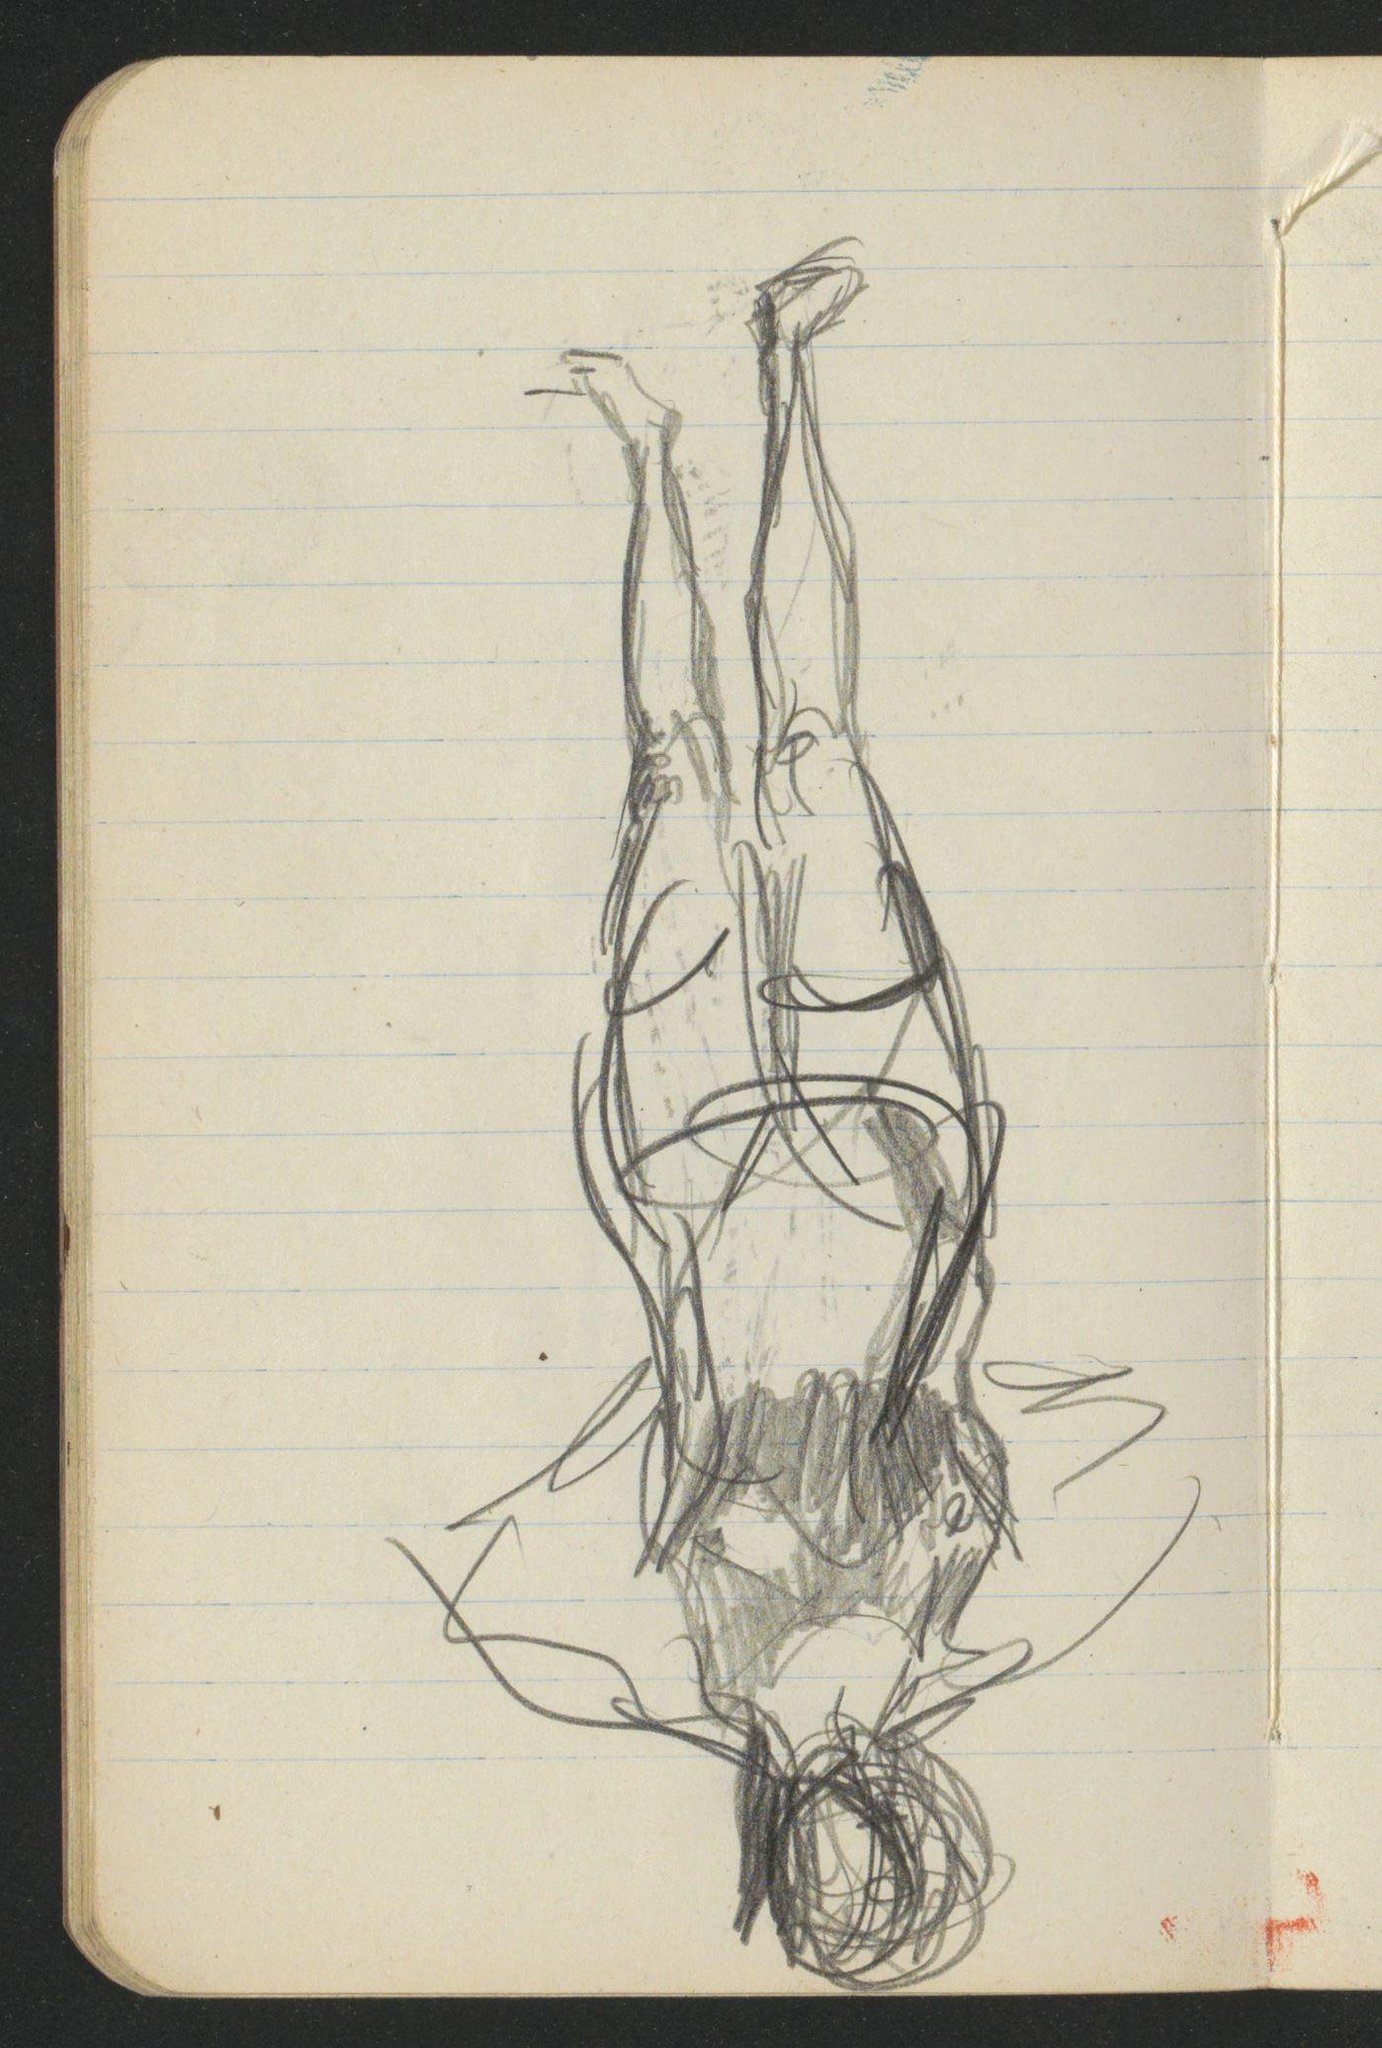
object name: sketchbook leaf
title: Staande vrouw, mogelijk in badkleding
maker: isaac israels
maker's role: draughtsman, painter, print maker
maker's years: 1865-1934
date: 1875-1934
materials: pencil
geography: the hague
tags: hand on the hip - aa - both arms or hands, adult woman (+ standing)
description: Haar handen in haar zij. Pagina 20 uit schetsboek XL met 40 pagina's.